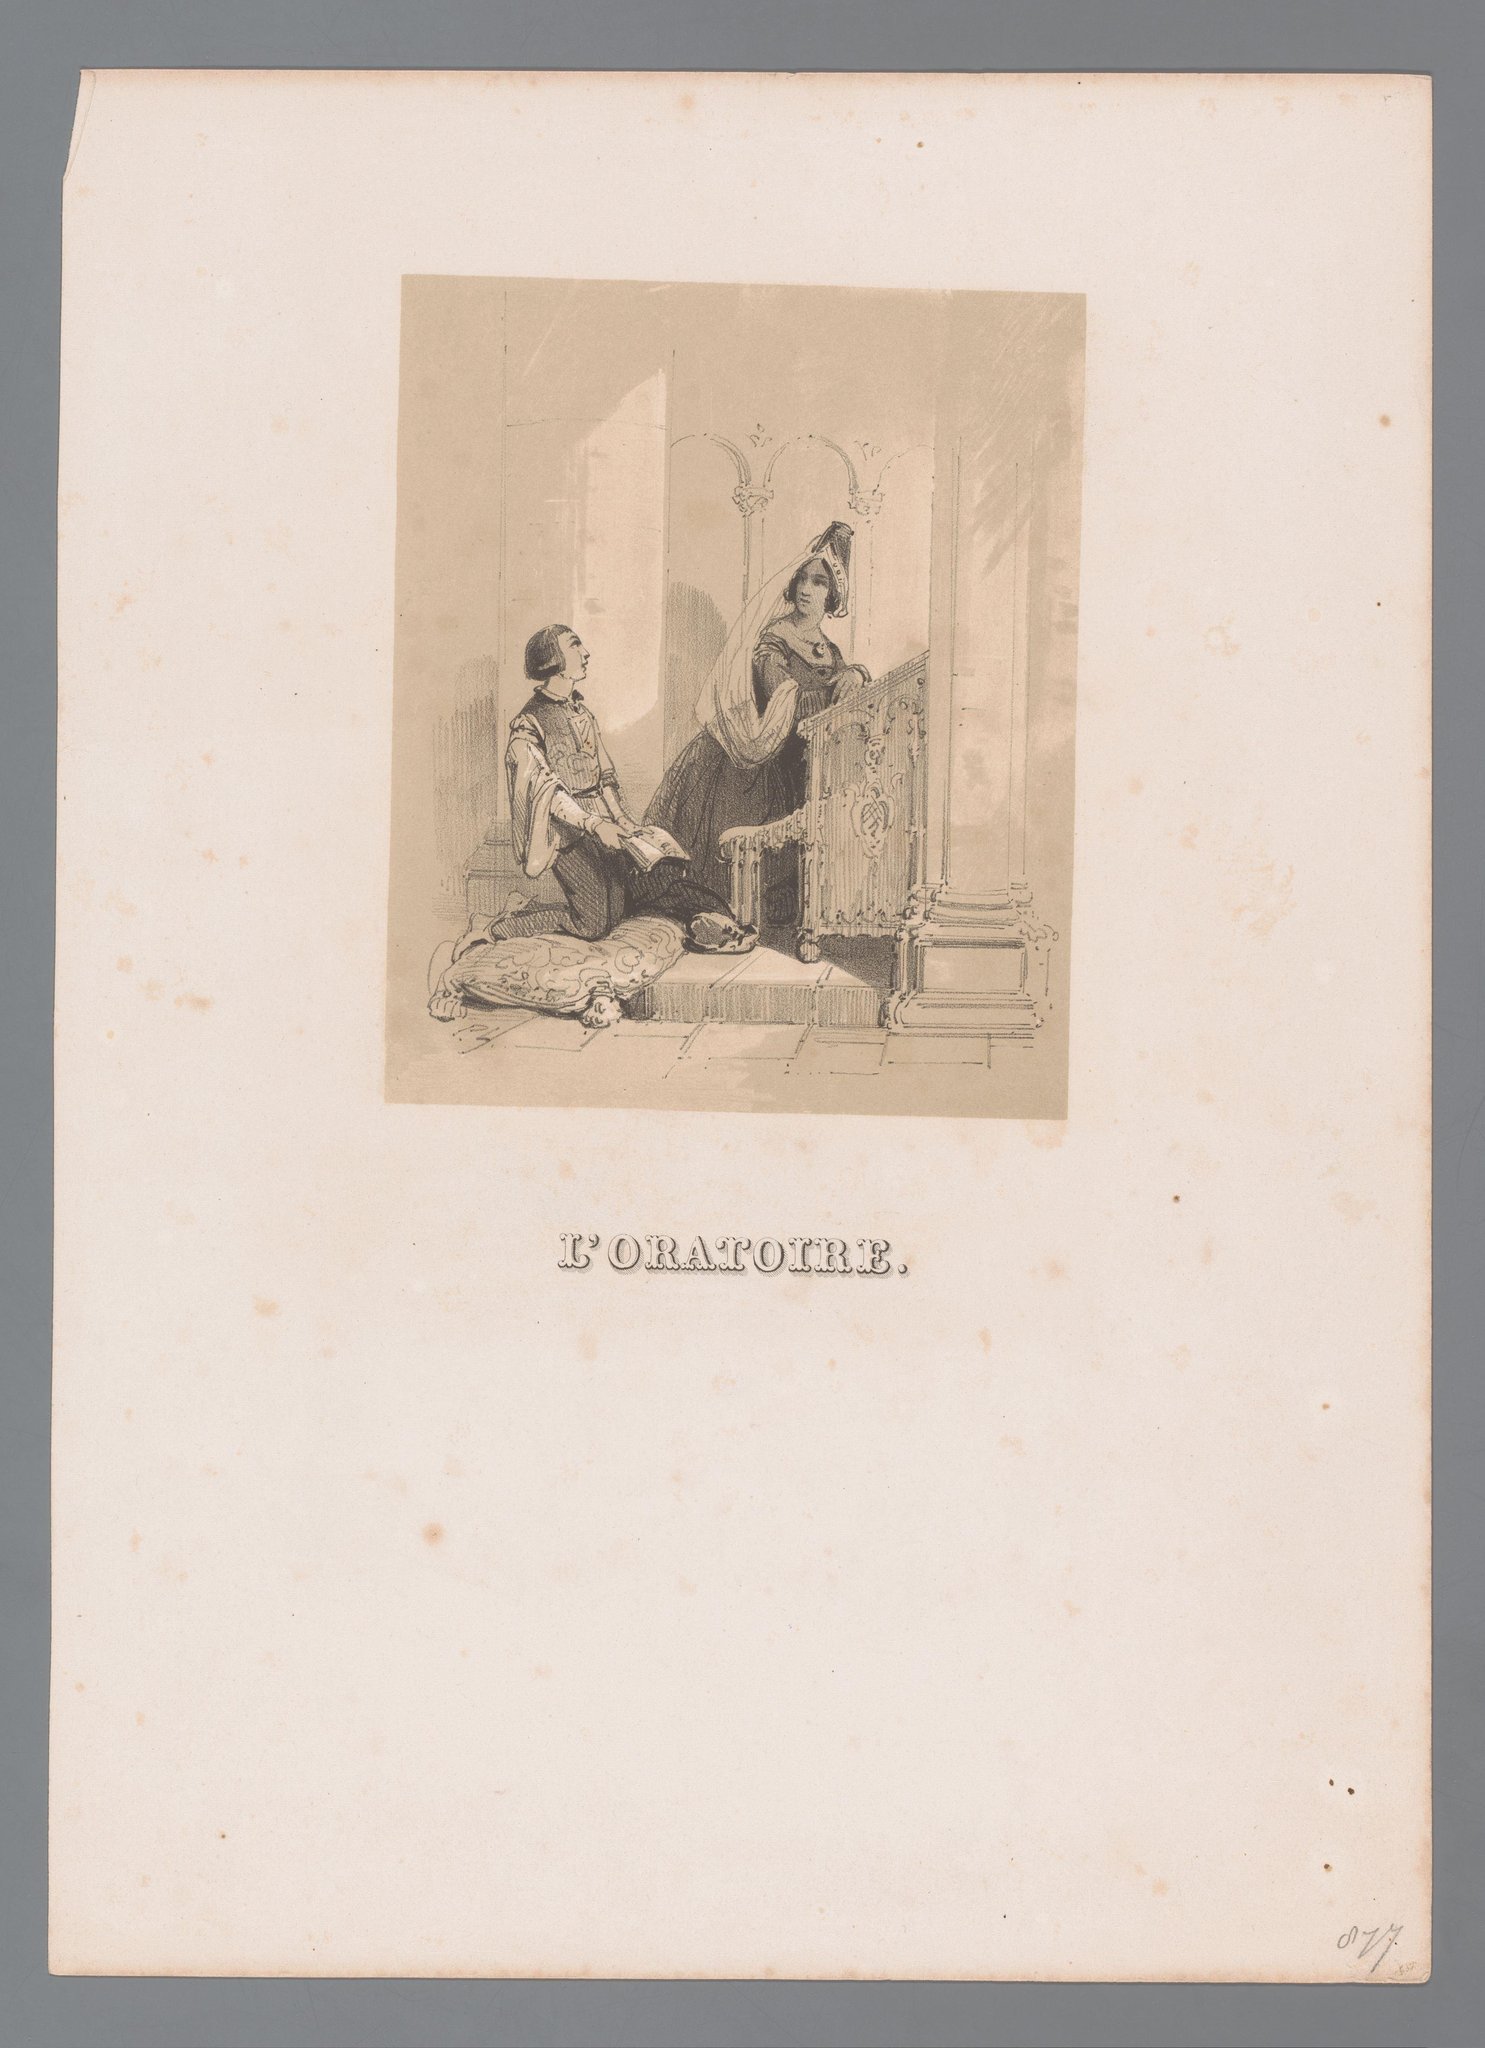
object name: print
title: L'Oratoire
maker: paulus lauters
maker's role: print maker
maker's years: 1806-1875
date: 1816-1875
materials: paper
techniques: tone lithography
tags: (private) prayer; 'oratione', 'preghiere', 'preghiere a dio' (ripa), altar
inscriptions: collector's mark: Lugt 2228